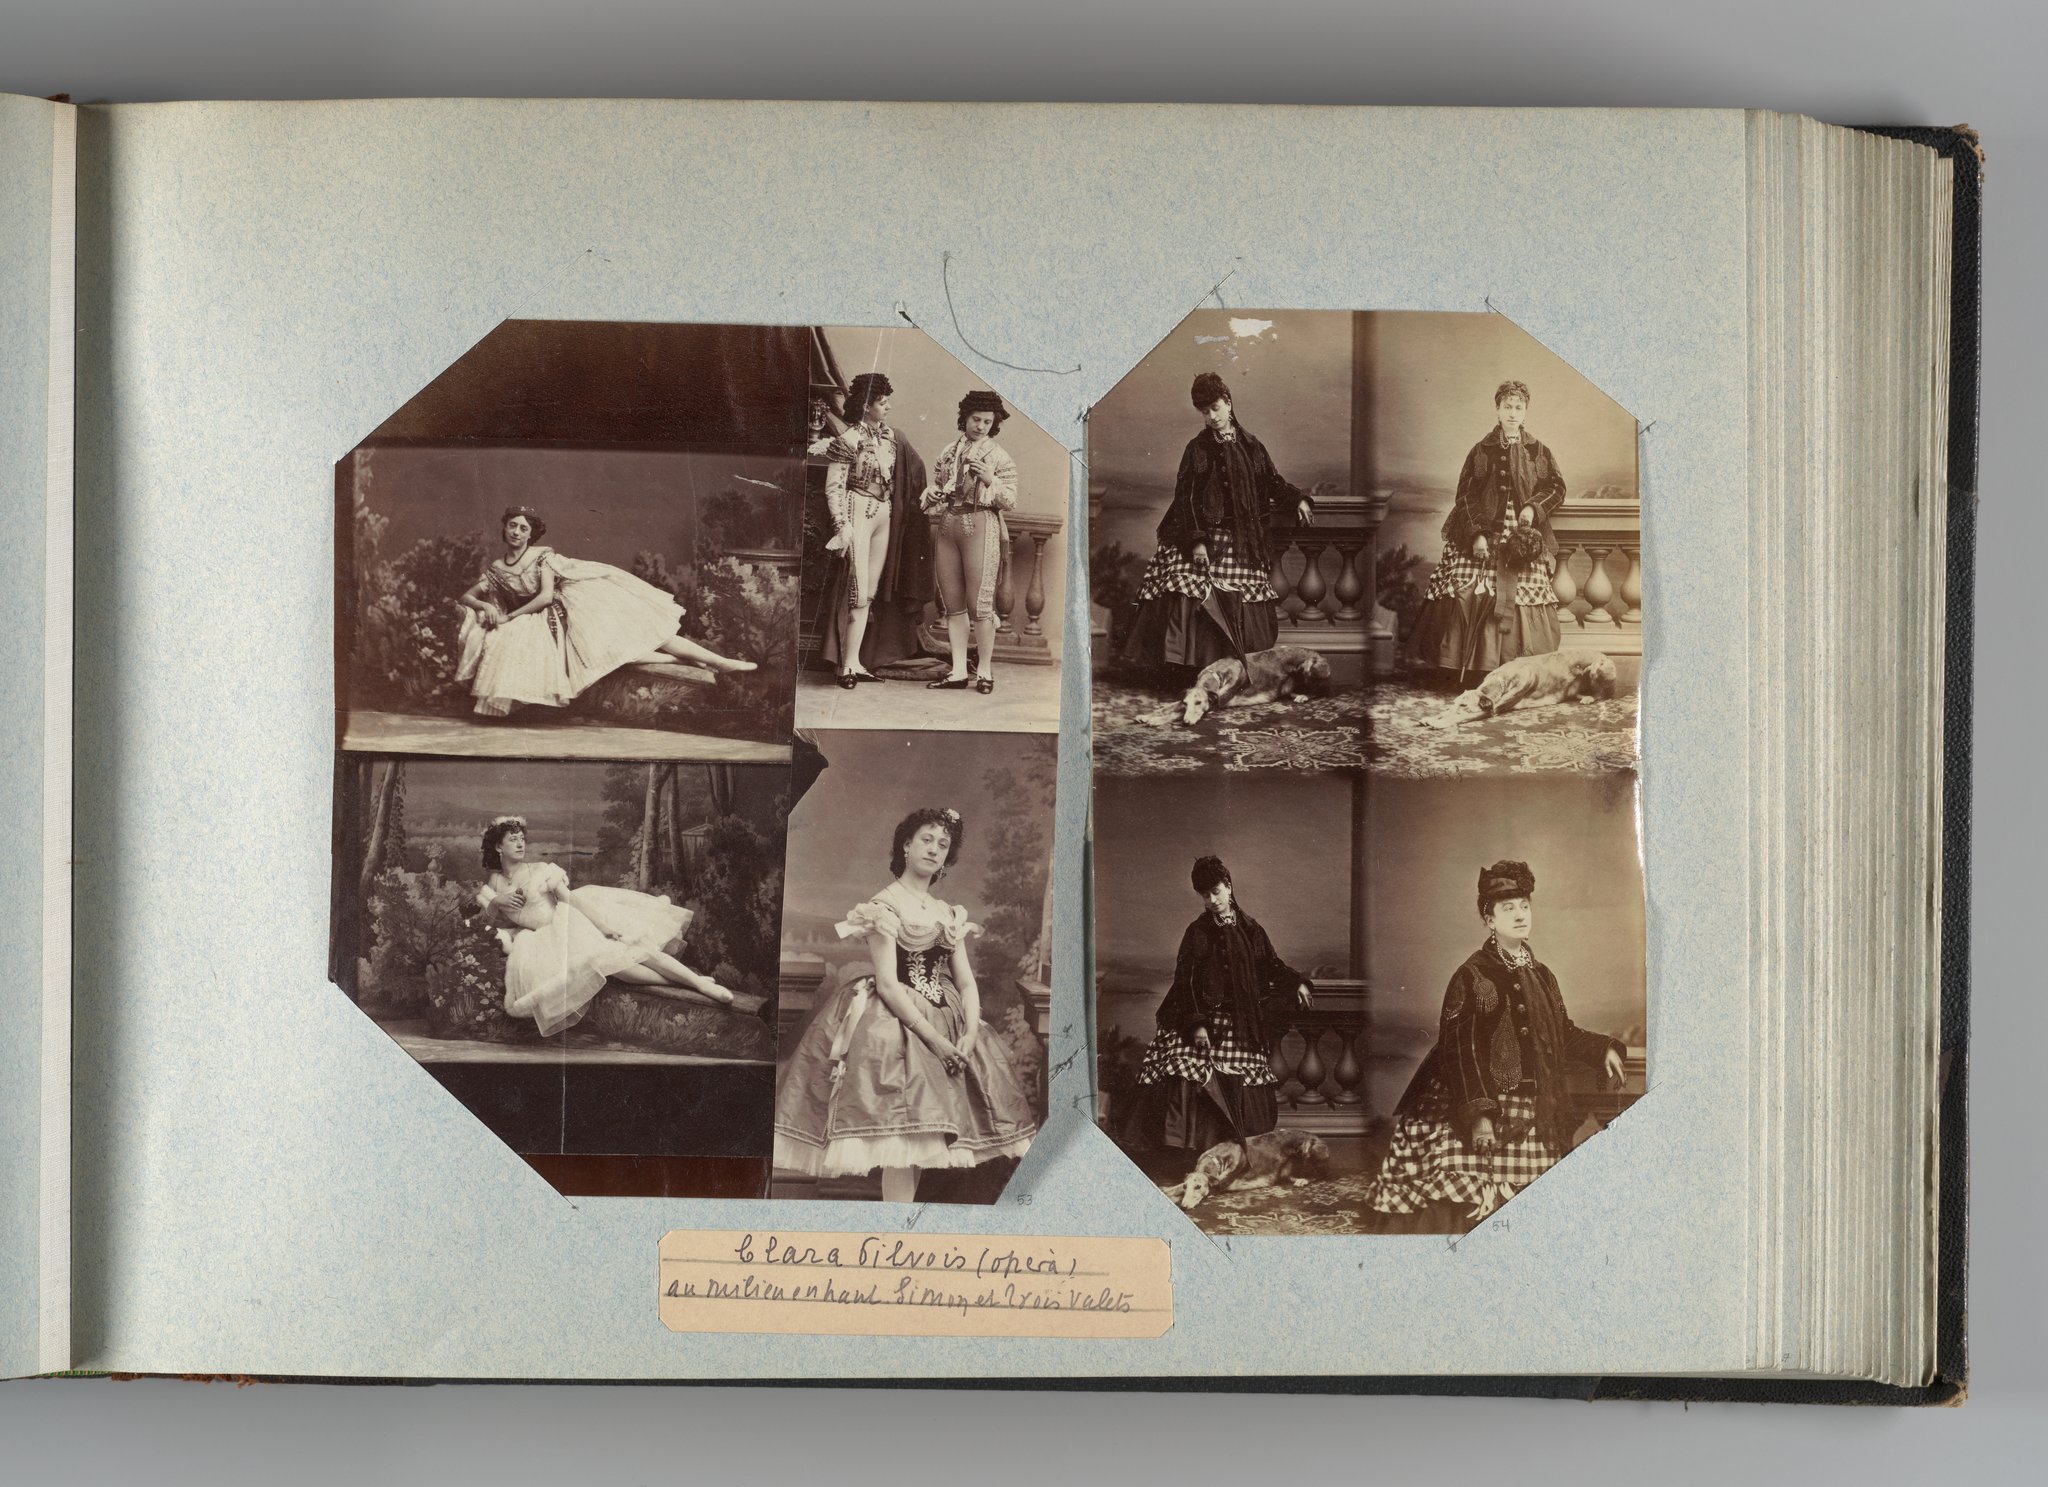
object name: photograph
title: Clara Pilvois; Simon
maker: andré-adolphe-eugène disdéri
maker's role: artist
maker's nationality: french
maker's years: 1819-1889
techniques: albumen silver print, glass negative